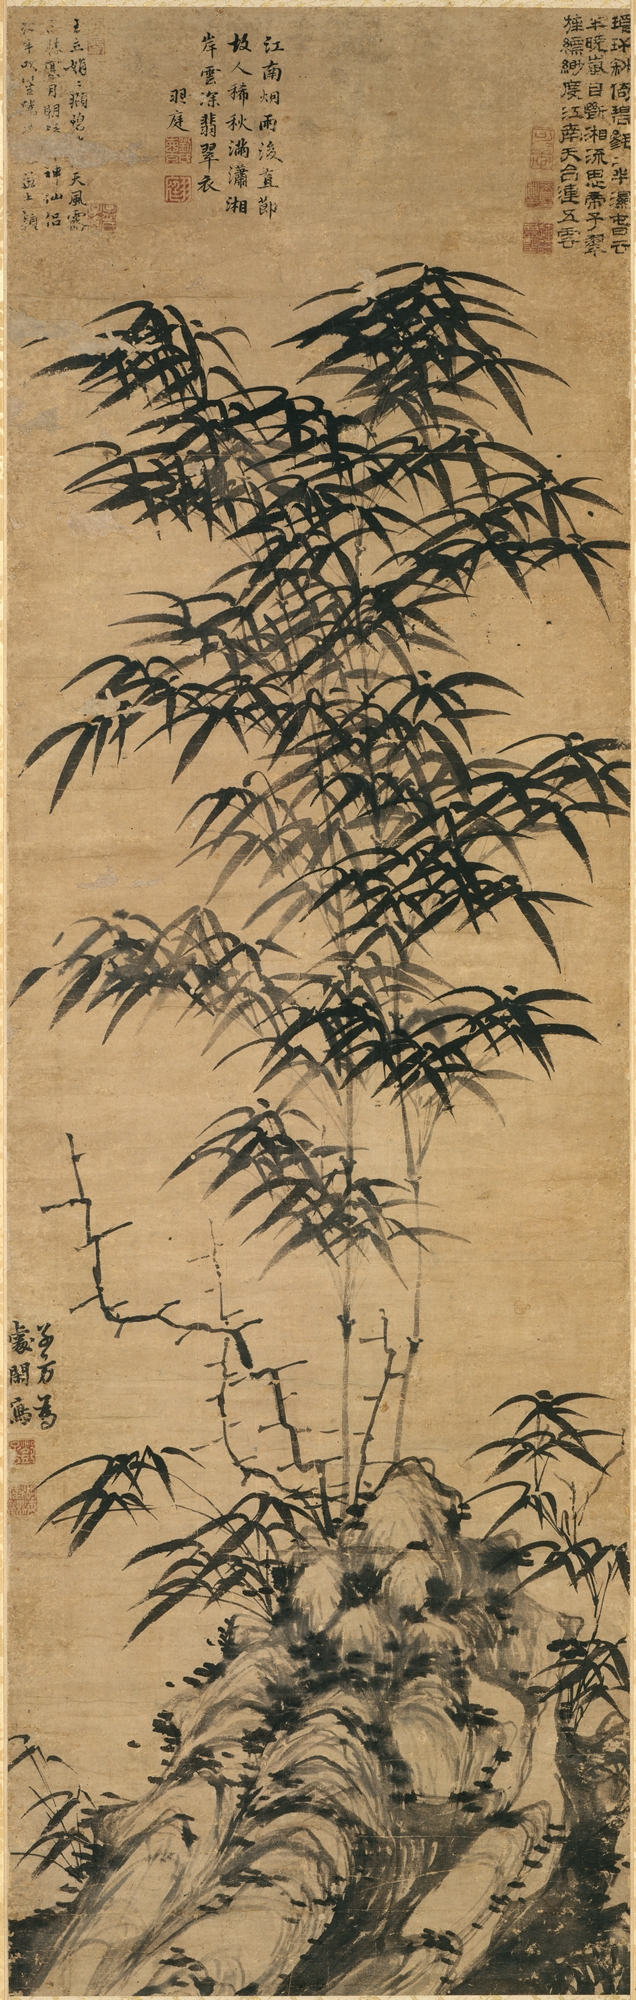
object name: hanging scroll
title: Bamboo and rock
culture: chinese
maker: deng yu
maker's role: artist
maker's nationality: chinese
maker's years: 1300-1378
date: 1360-1367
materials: ink, paper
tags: bamboo